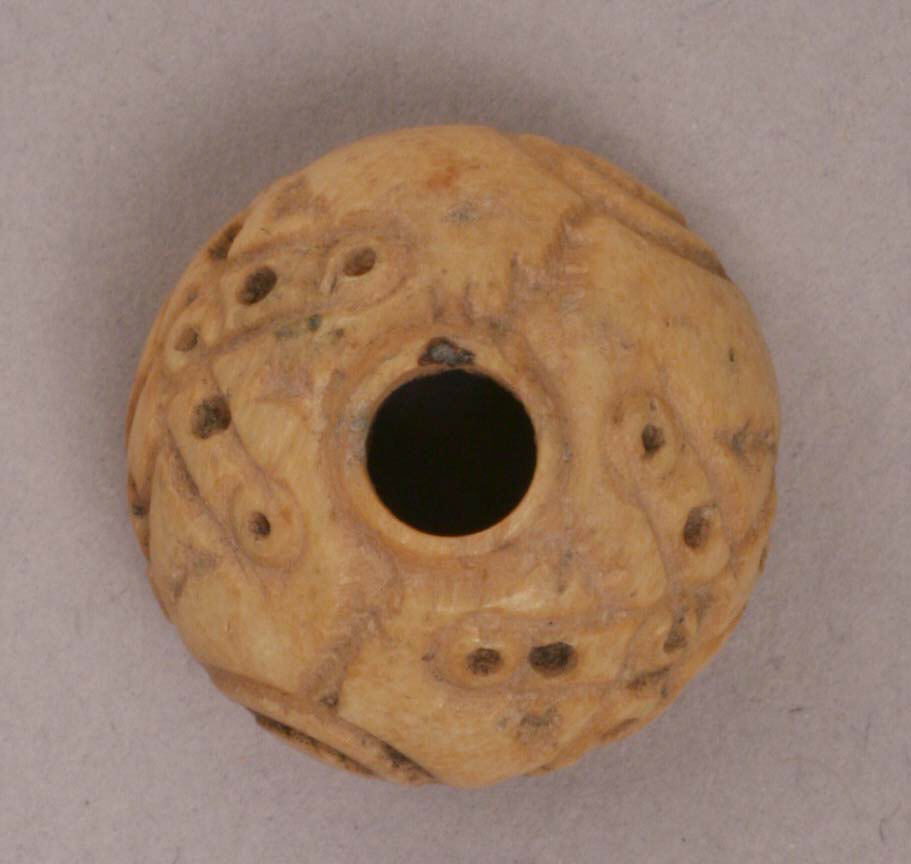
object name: button or bead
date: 801-1000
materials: bone, paint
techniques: incising, inlay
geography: iran